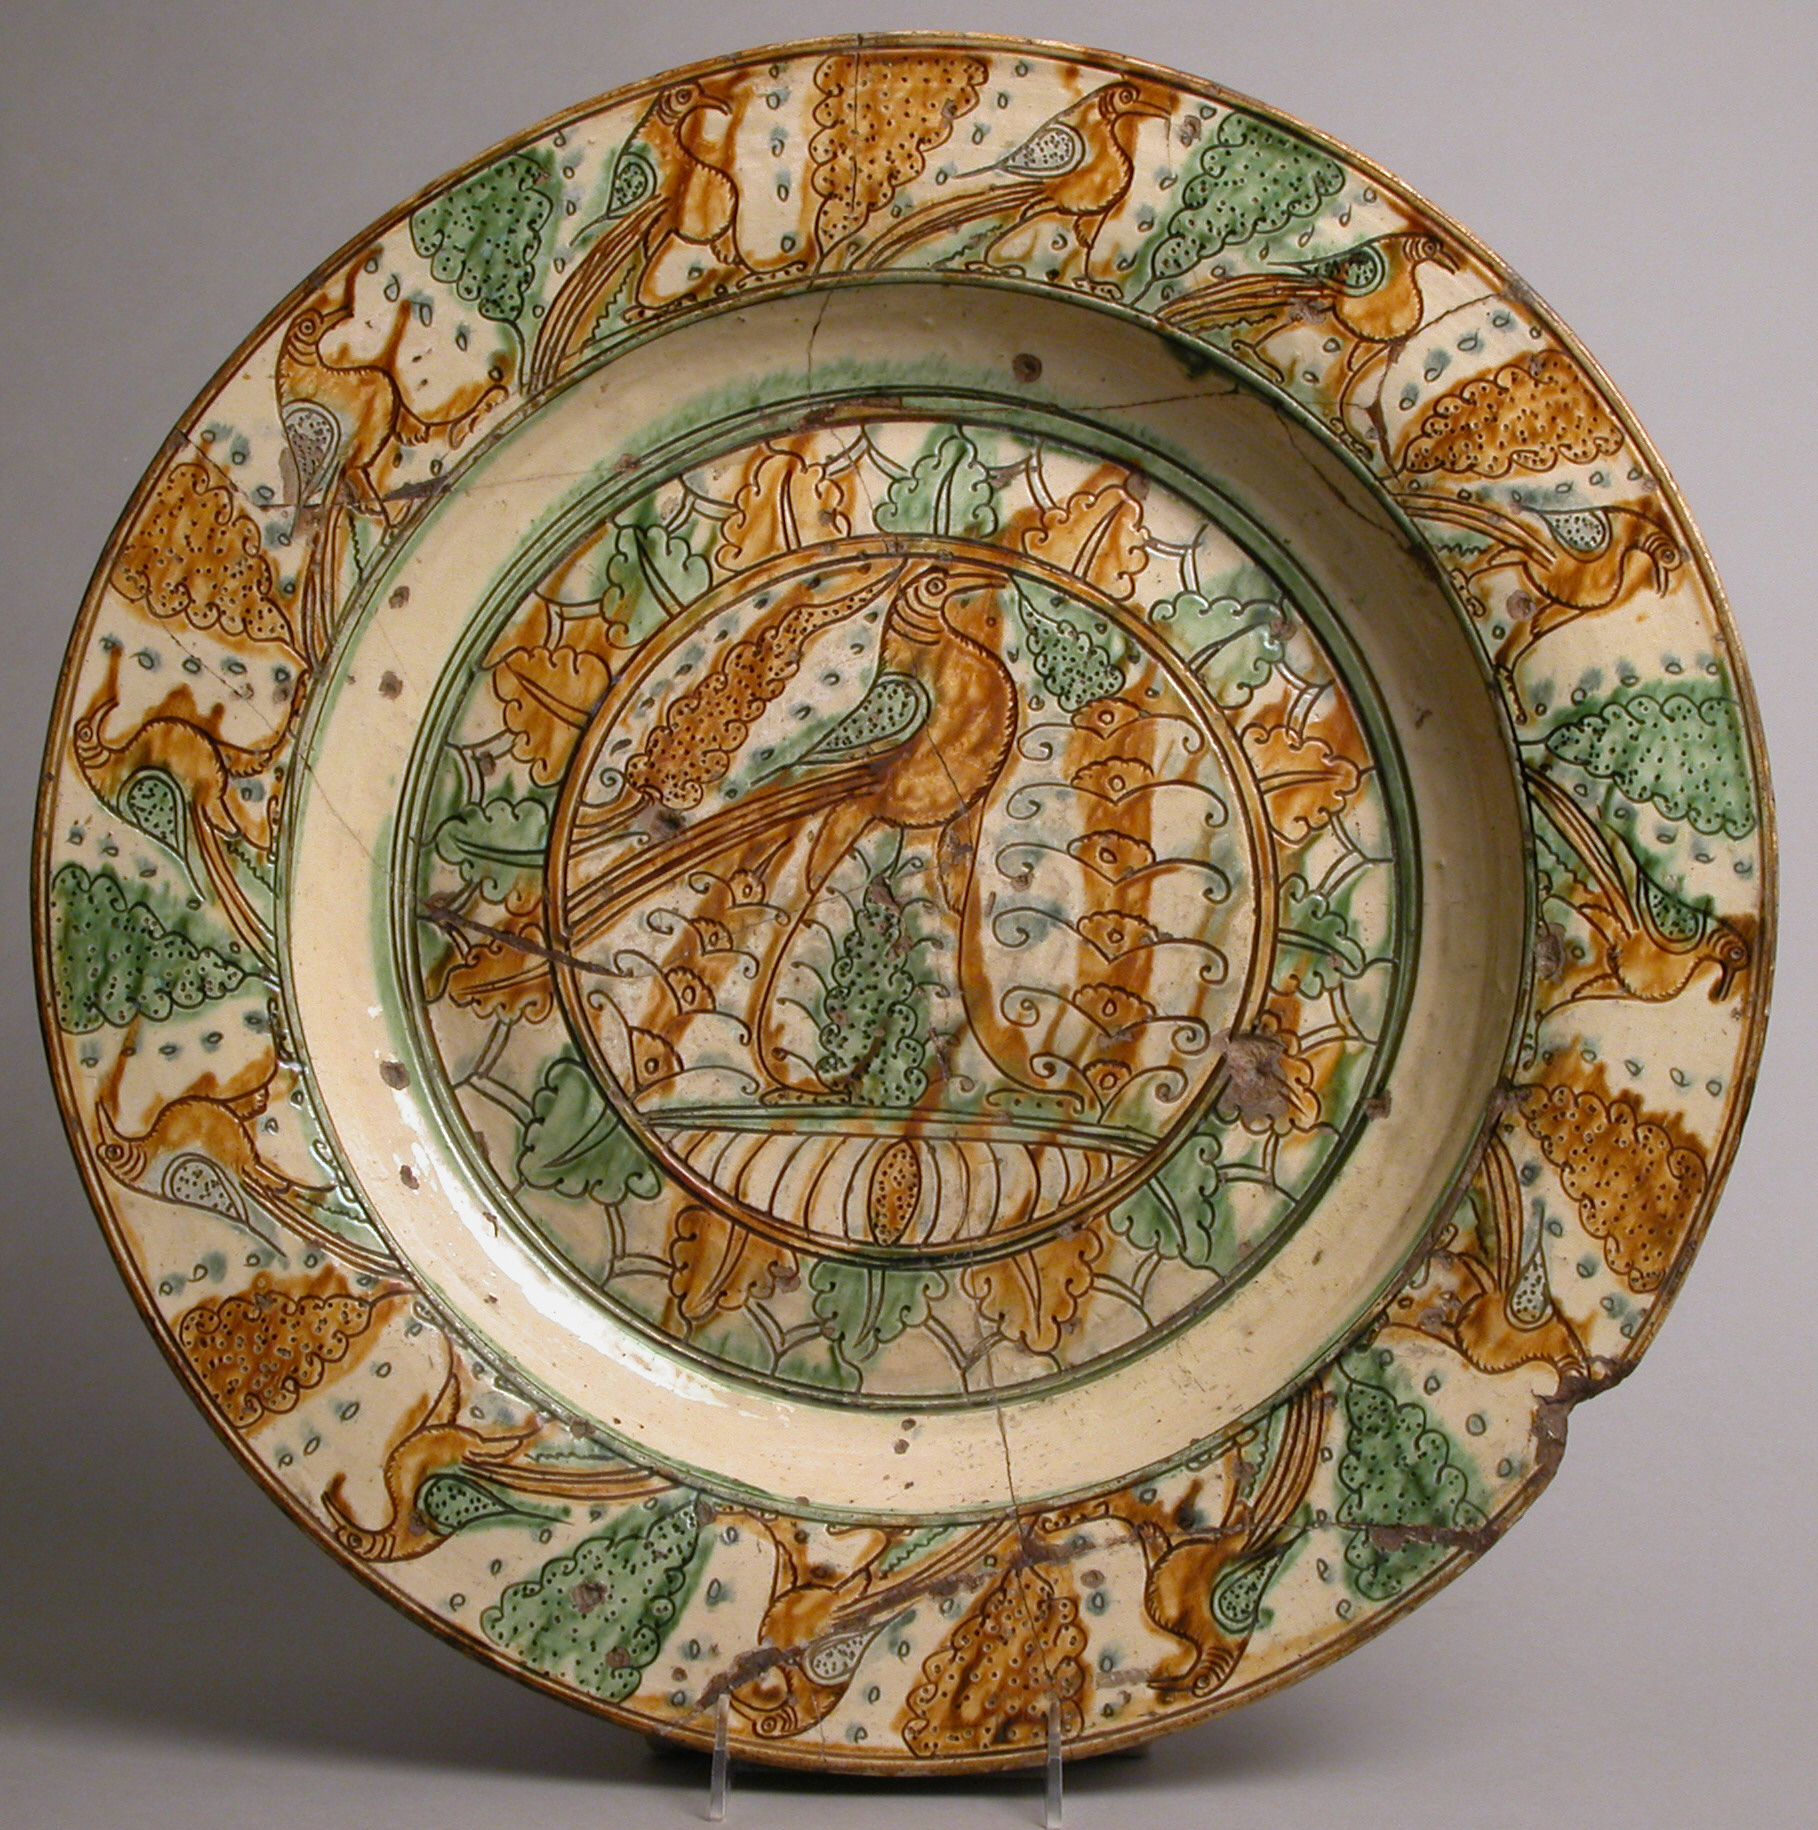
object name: plate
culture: italian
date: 1401-1500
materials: earthenware, glaze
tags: birds